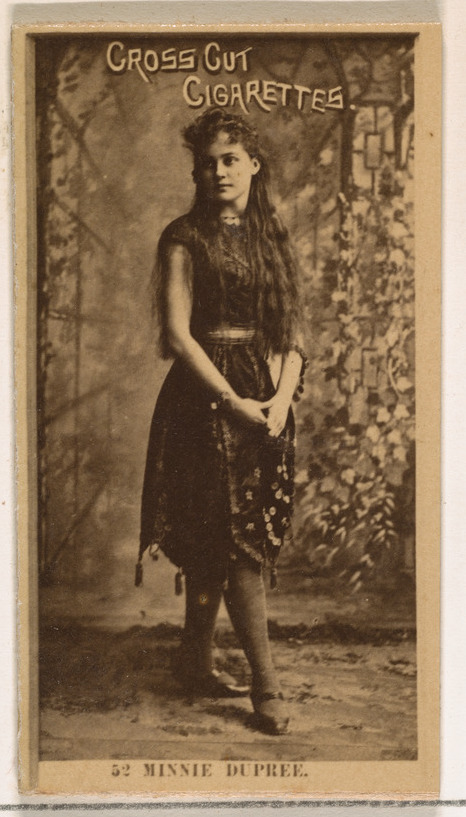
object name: print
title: Card Number 52, Minnie Dupree, from the Actors and Actresses series (N145-2) issued by Duke Sons & Co. to promote Cross Cut Cigarettes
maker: w. duke, sons & co.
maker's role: publisher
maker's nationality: american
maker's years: 1870-1920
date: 1880-1889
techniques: albumen silver print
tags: portraits,women,actresses